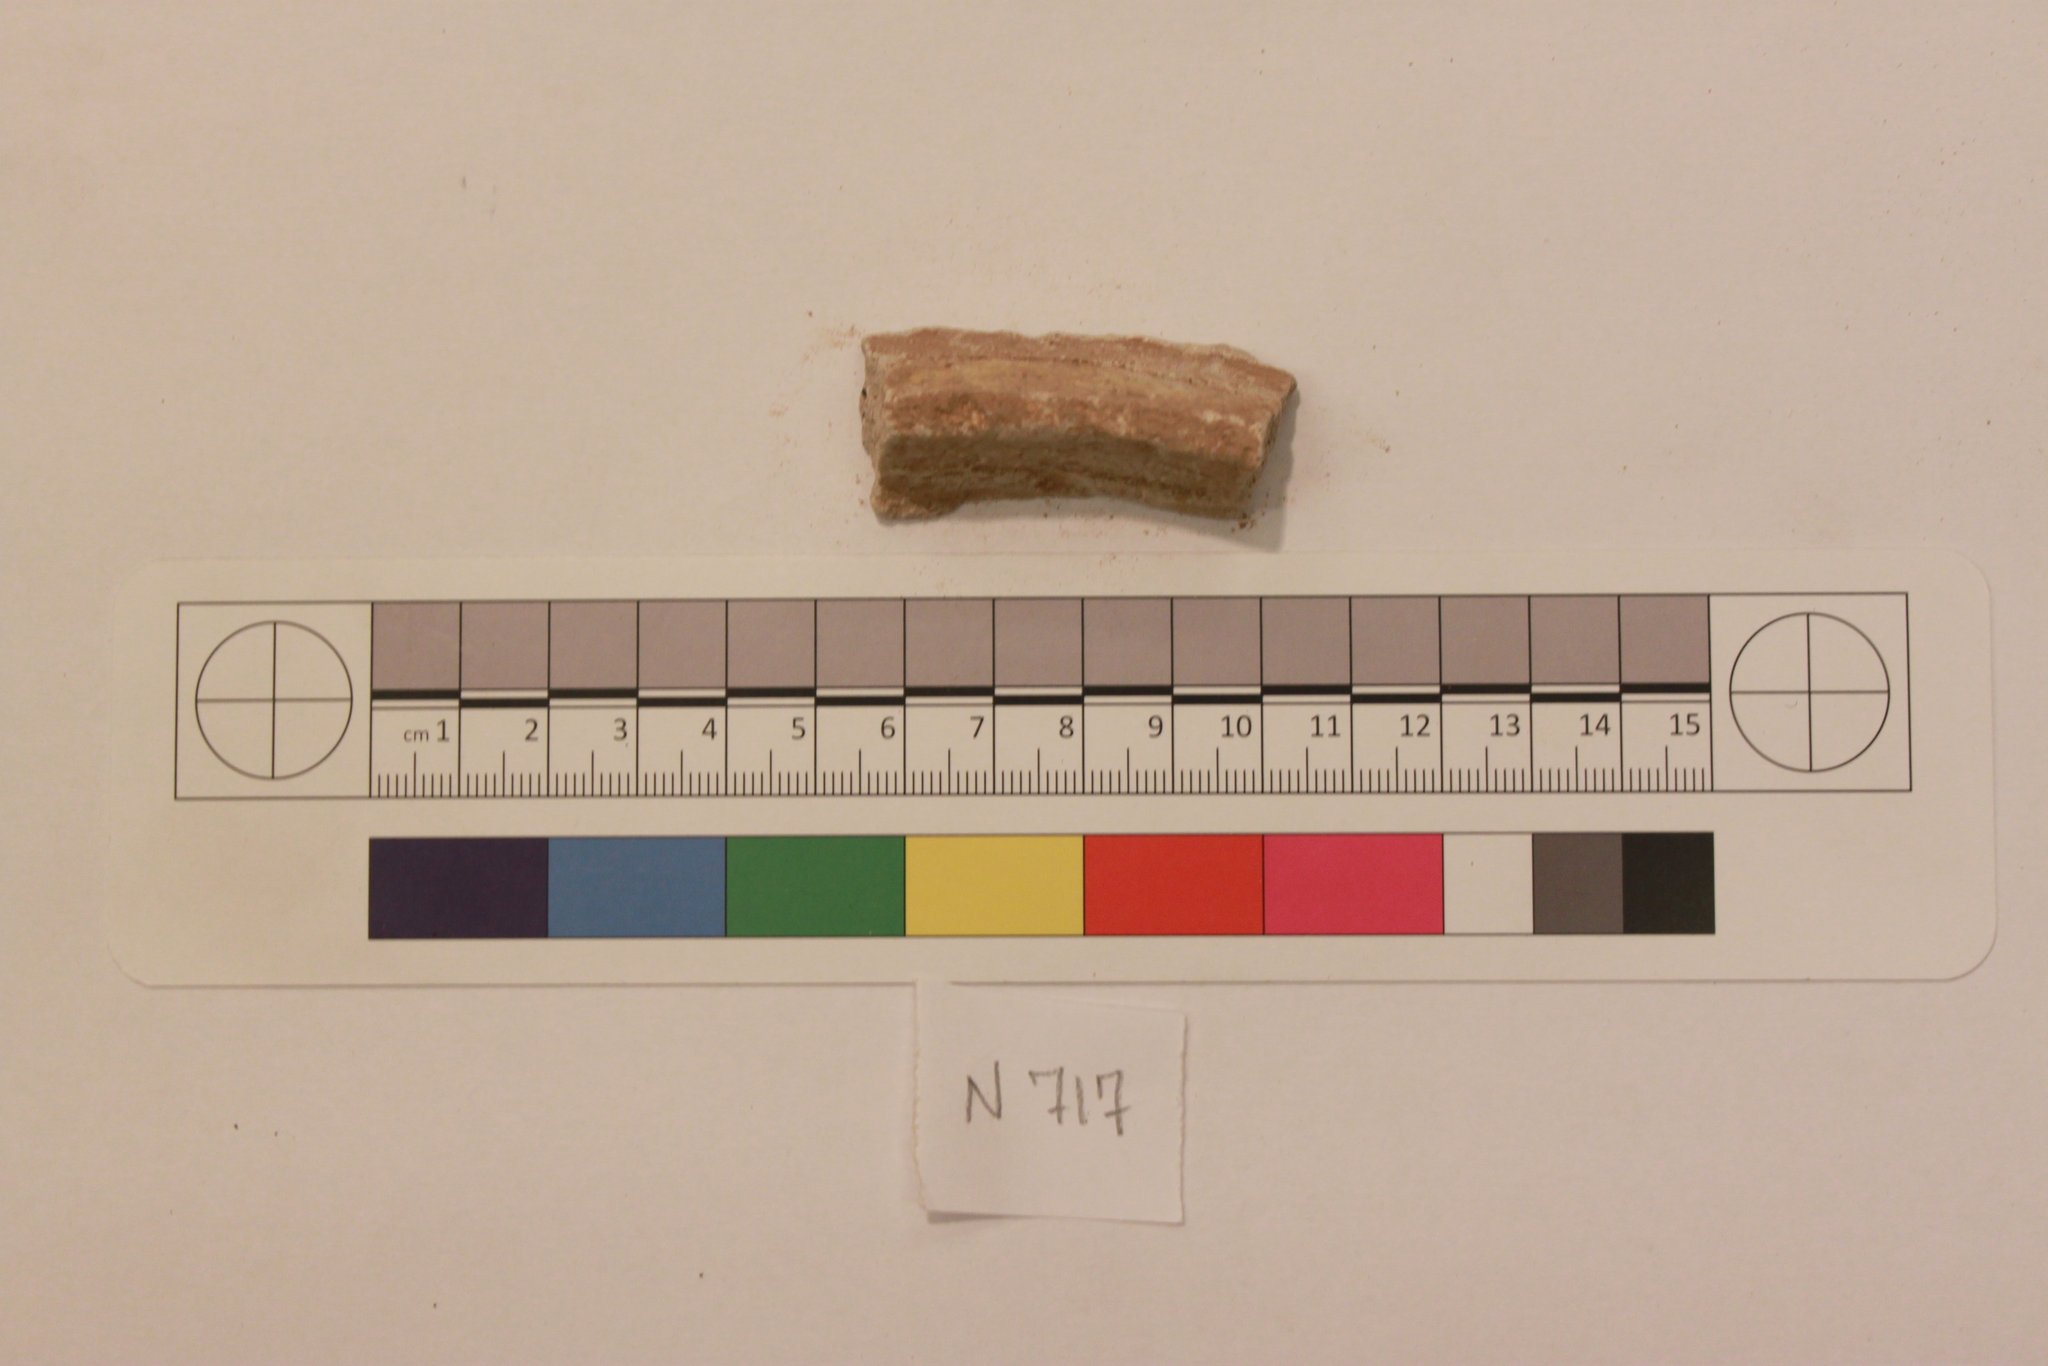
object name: fragment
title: Stucco Fragment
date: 701-1200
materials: plaster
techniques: carving, painting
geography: iran